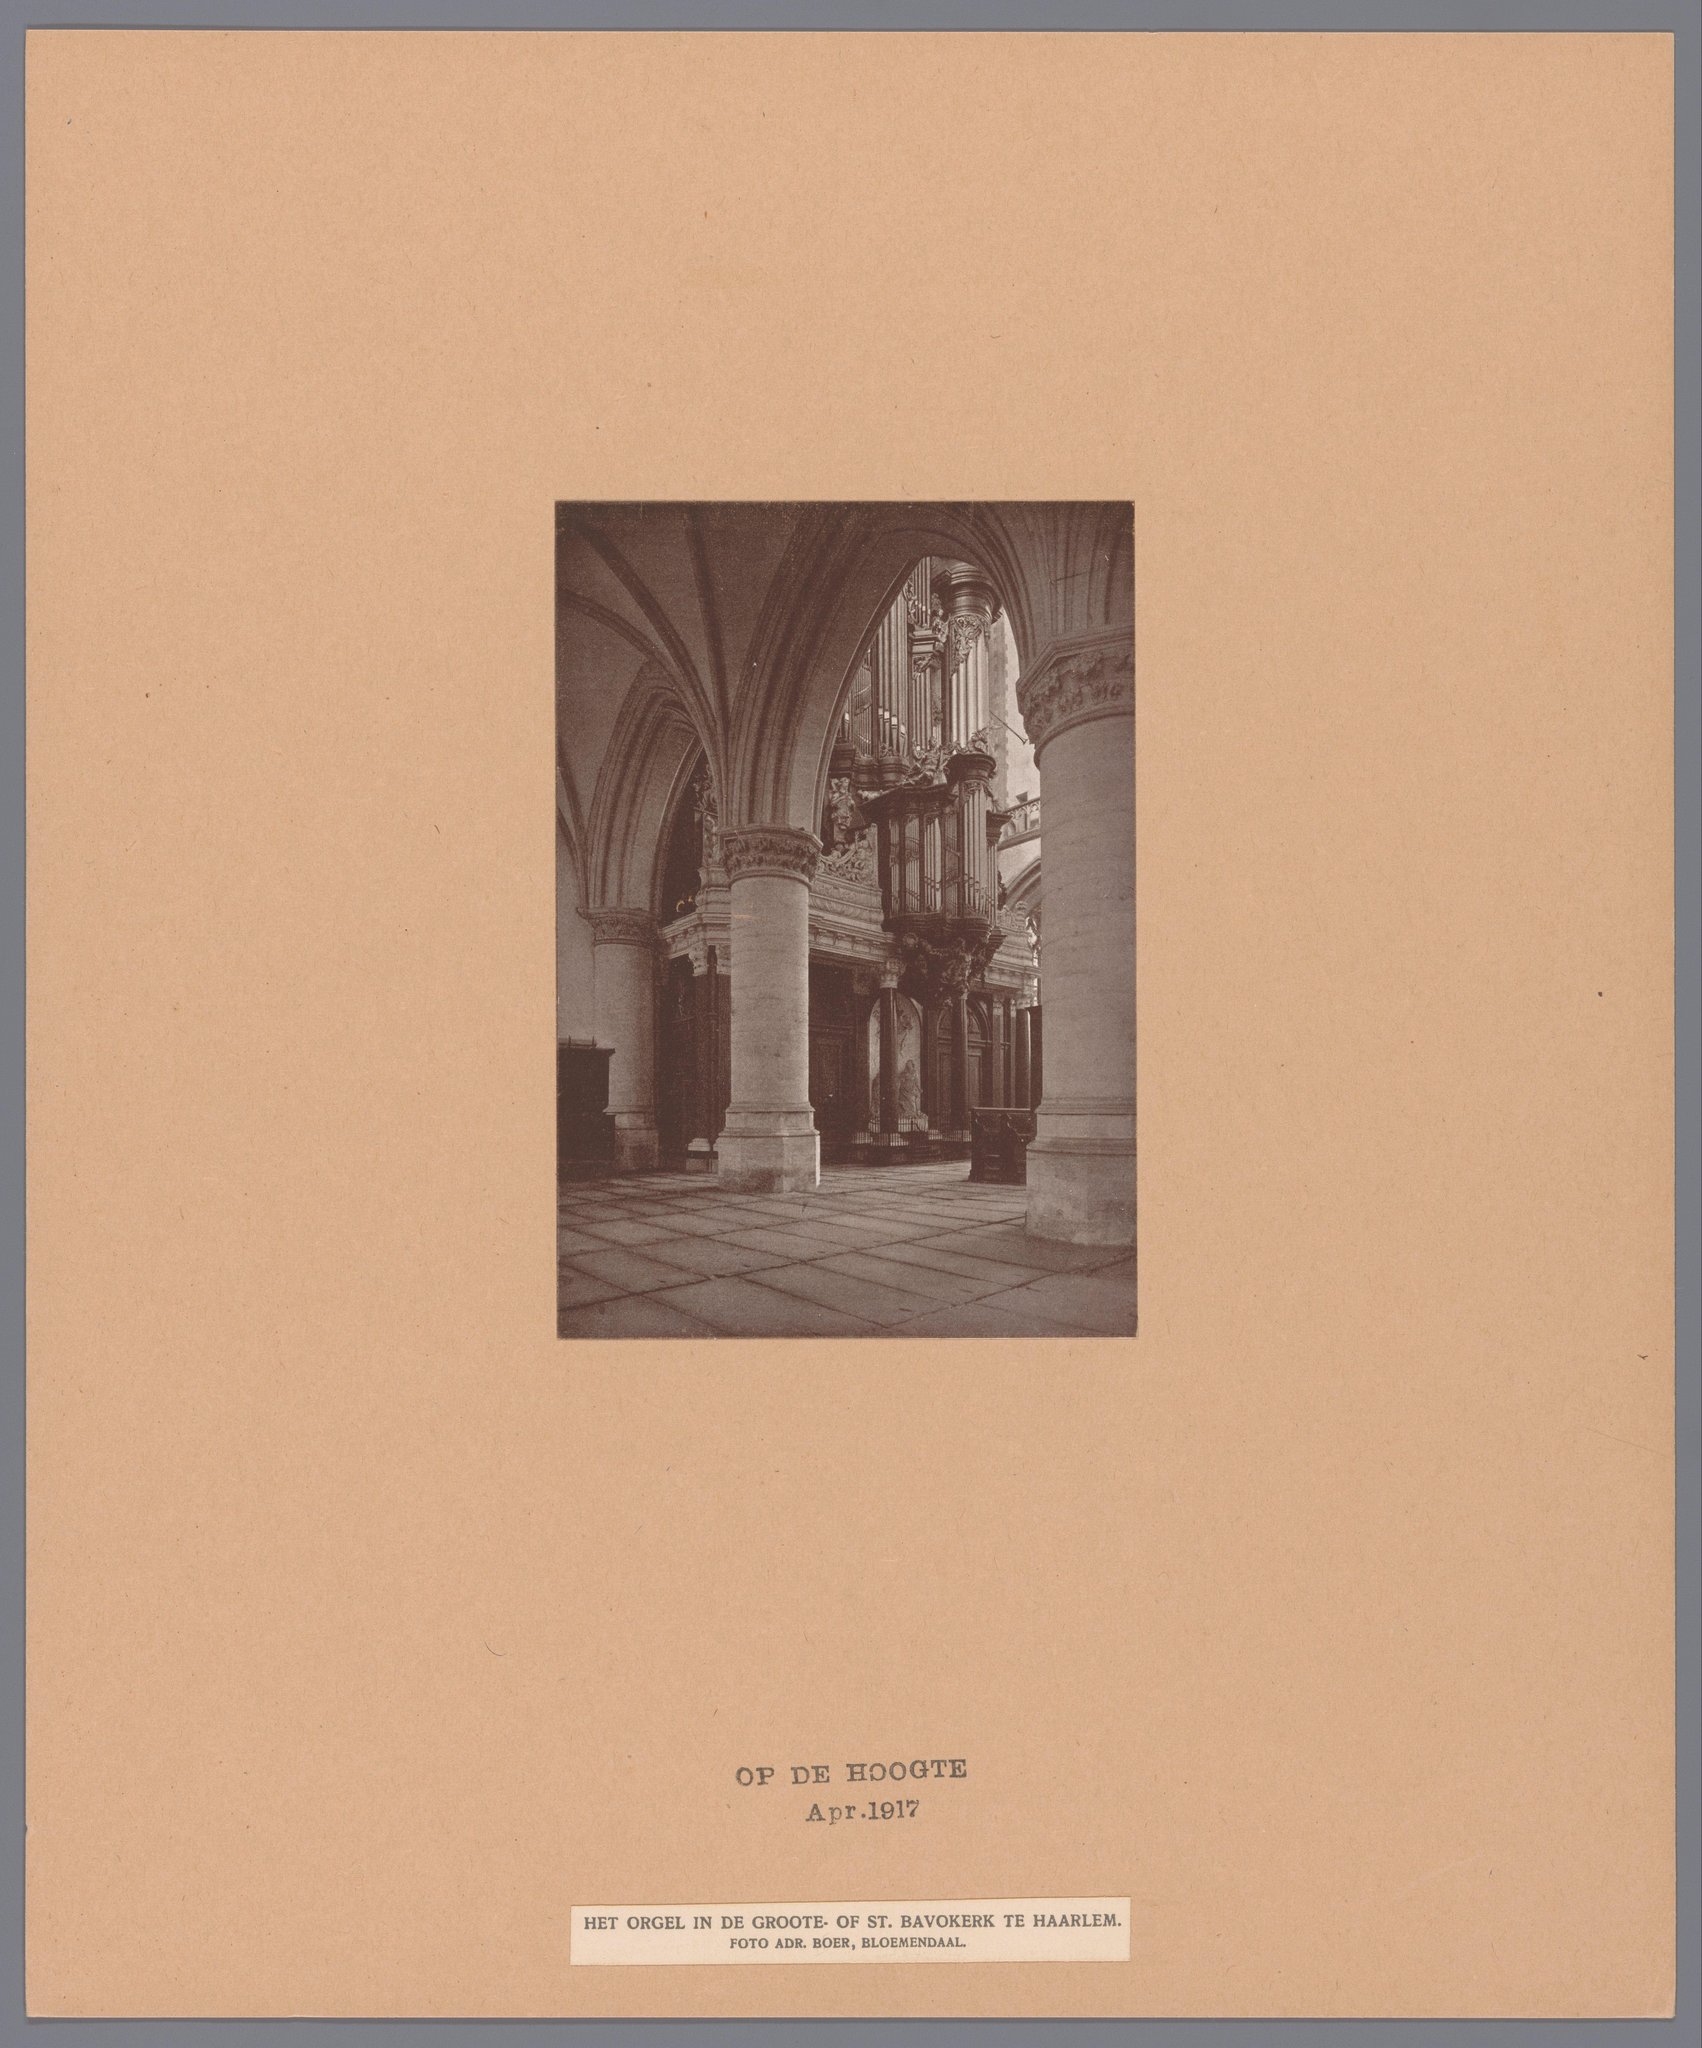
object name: photomechanical print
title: Interieur met orgel van de Sint-Bavokerk te Haarlem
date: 1912-1917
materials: paper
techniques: autotype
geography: haarlem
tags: church (exterior)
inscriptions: inscription: ‘Het orgel in de Groote- of St. Bavokerk te Haarlem/ foto Adr. Boer, Bloemendaal’, inscription: ‘Op de hoogte/ Apr.1917’